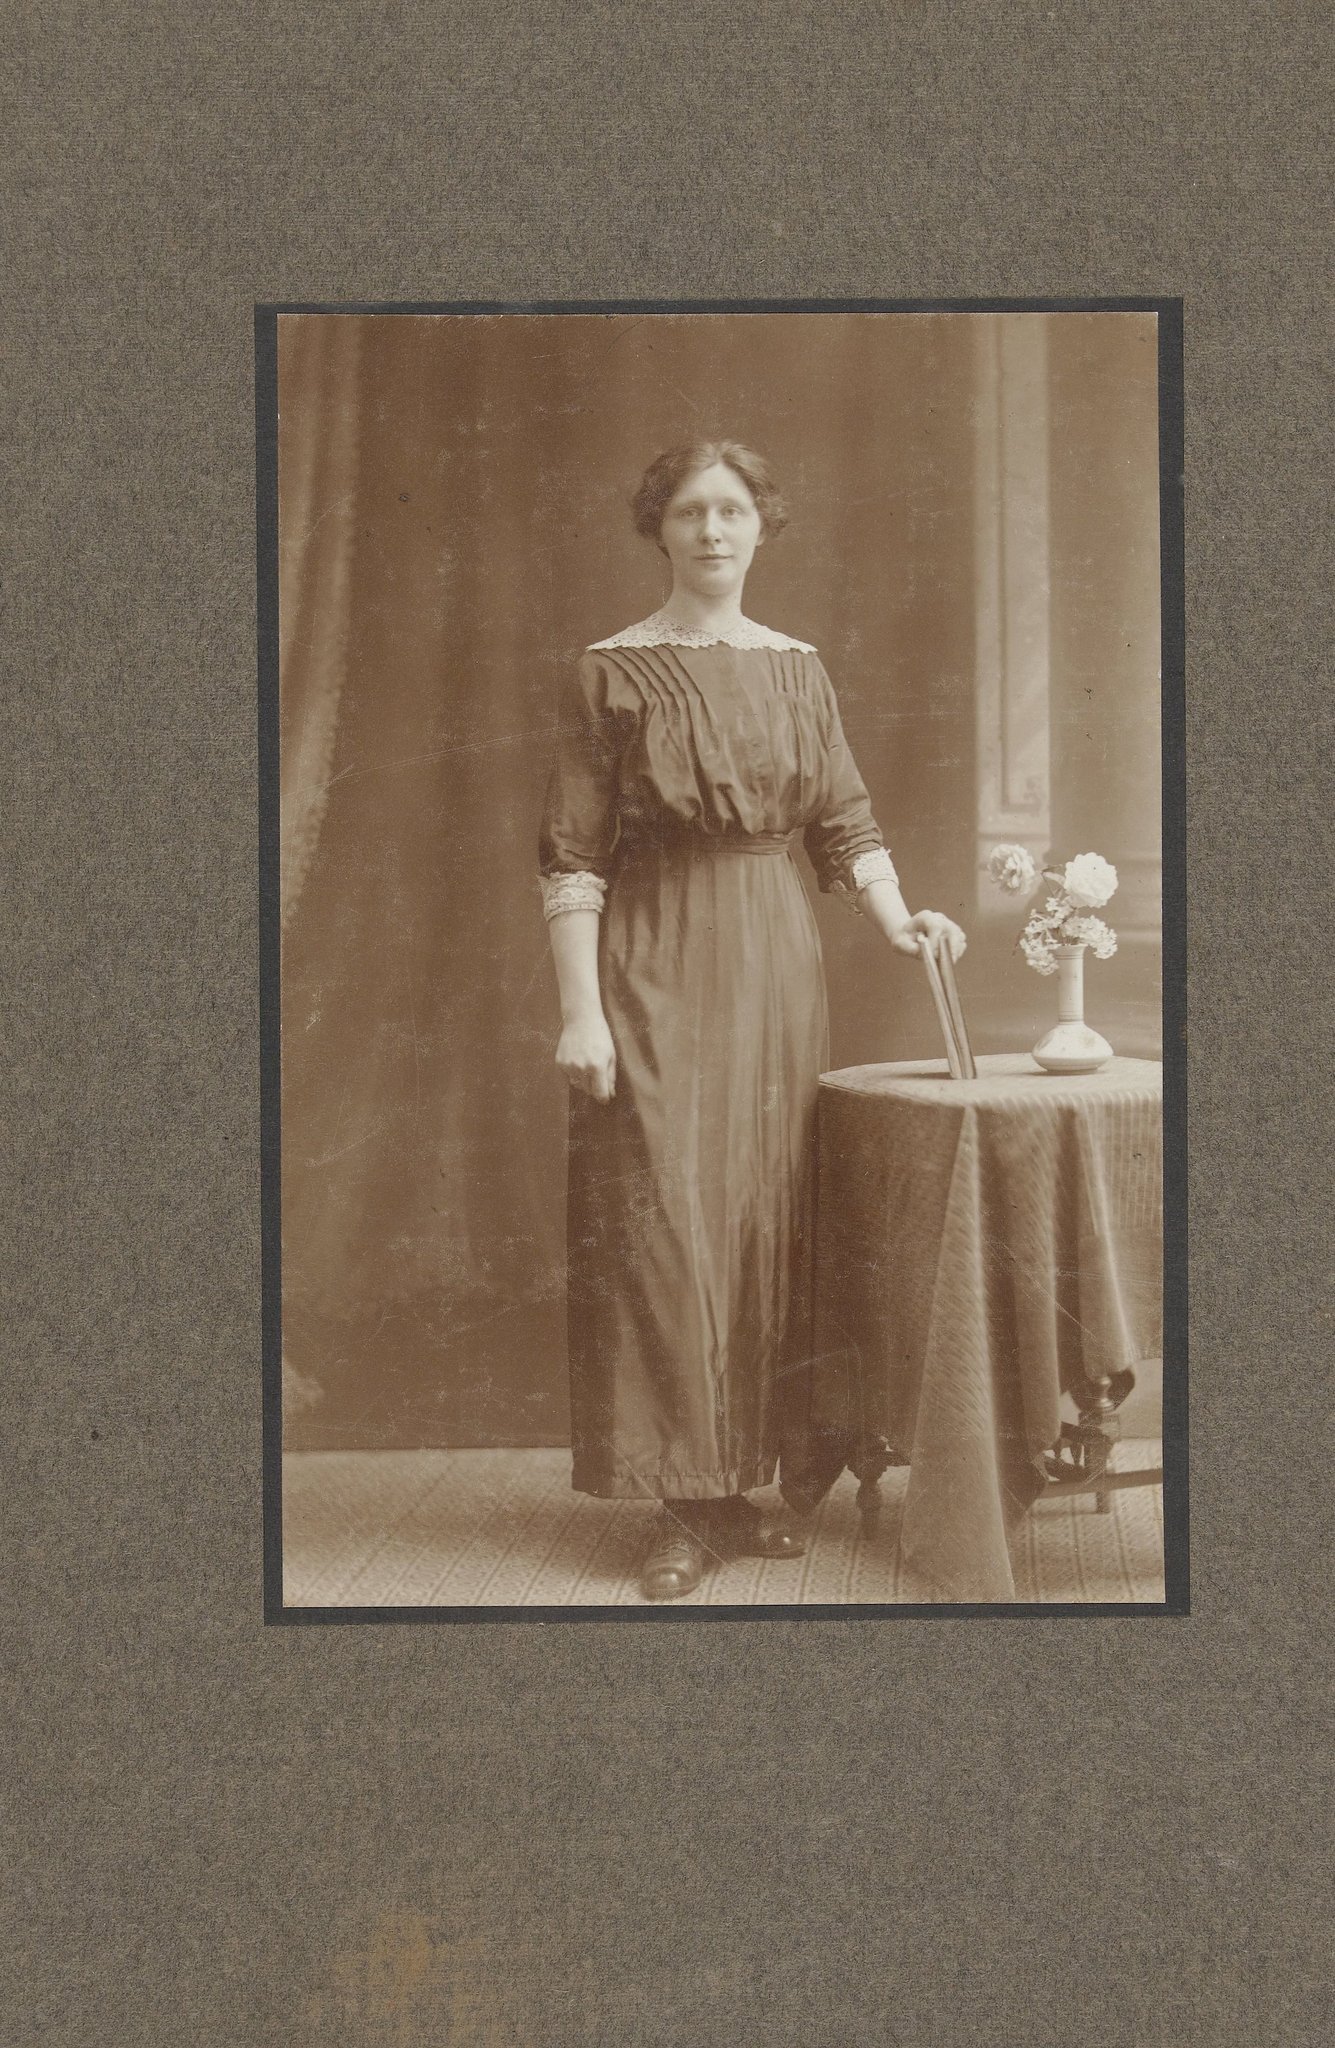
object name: photograph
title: Studioportret van een vrouw met een boek bij tafel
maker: Anonymous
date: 1910-1920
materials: cardboard, photographic support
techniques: collodion silver print